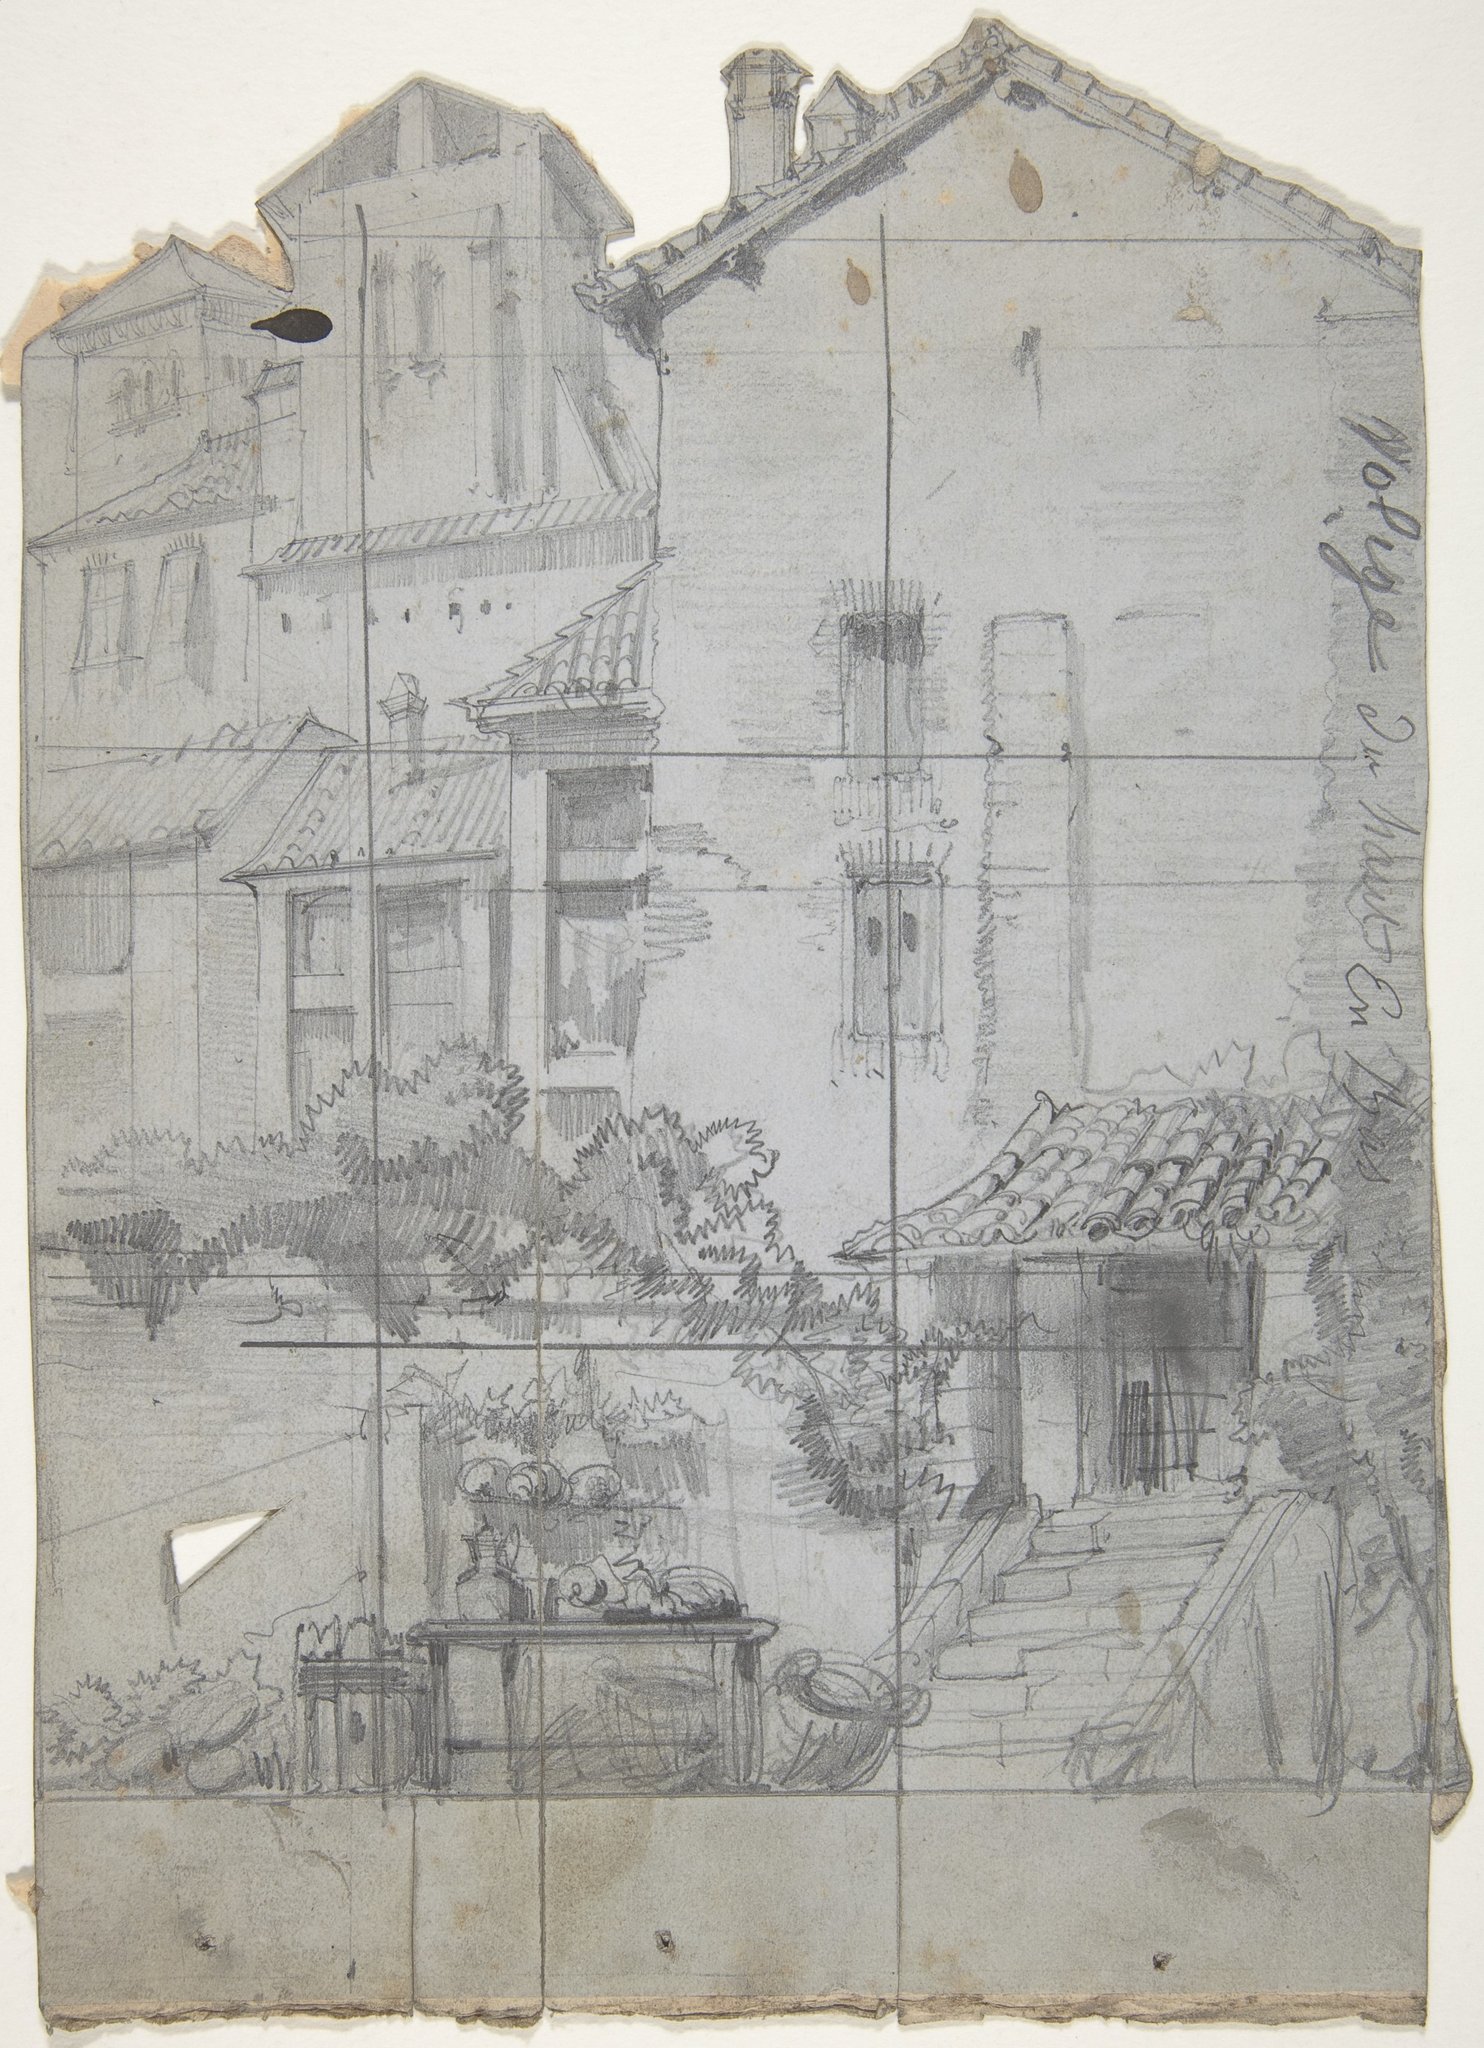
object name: drawing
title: Design for a Stage Set at the Opéra, Paris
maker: eugène cicéri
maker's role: artist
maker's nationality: french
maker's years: 1813-1890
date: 1830-1890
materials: graphite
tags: buildings,stage design